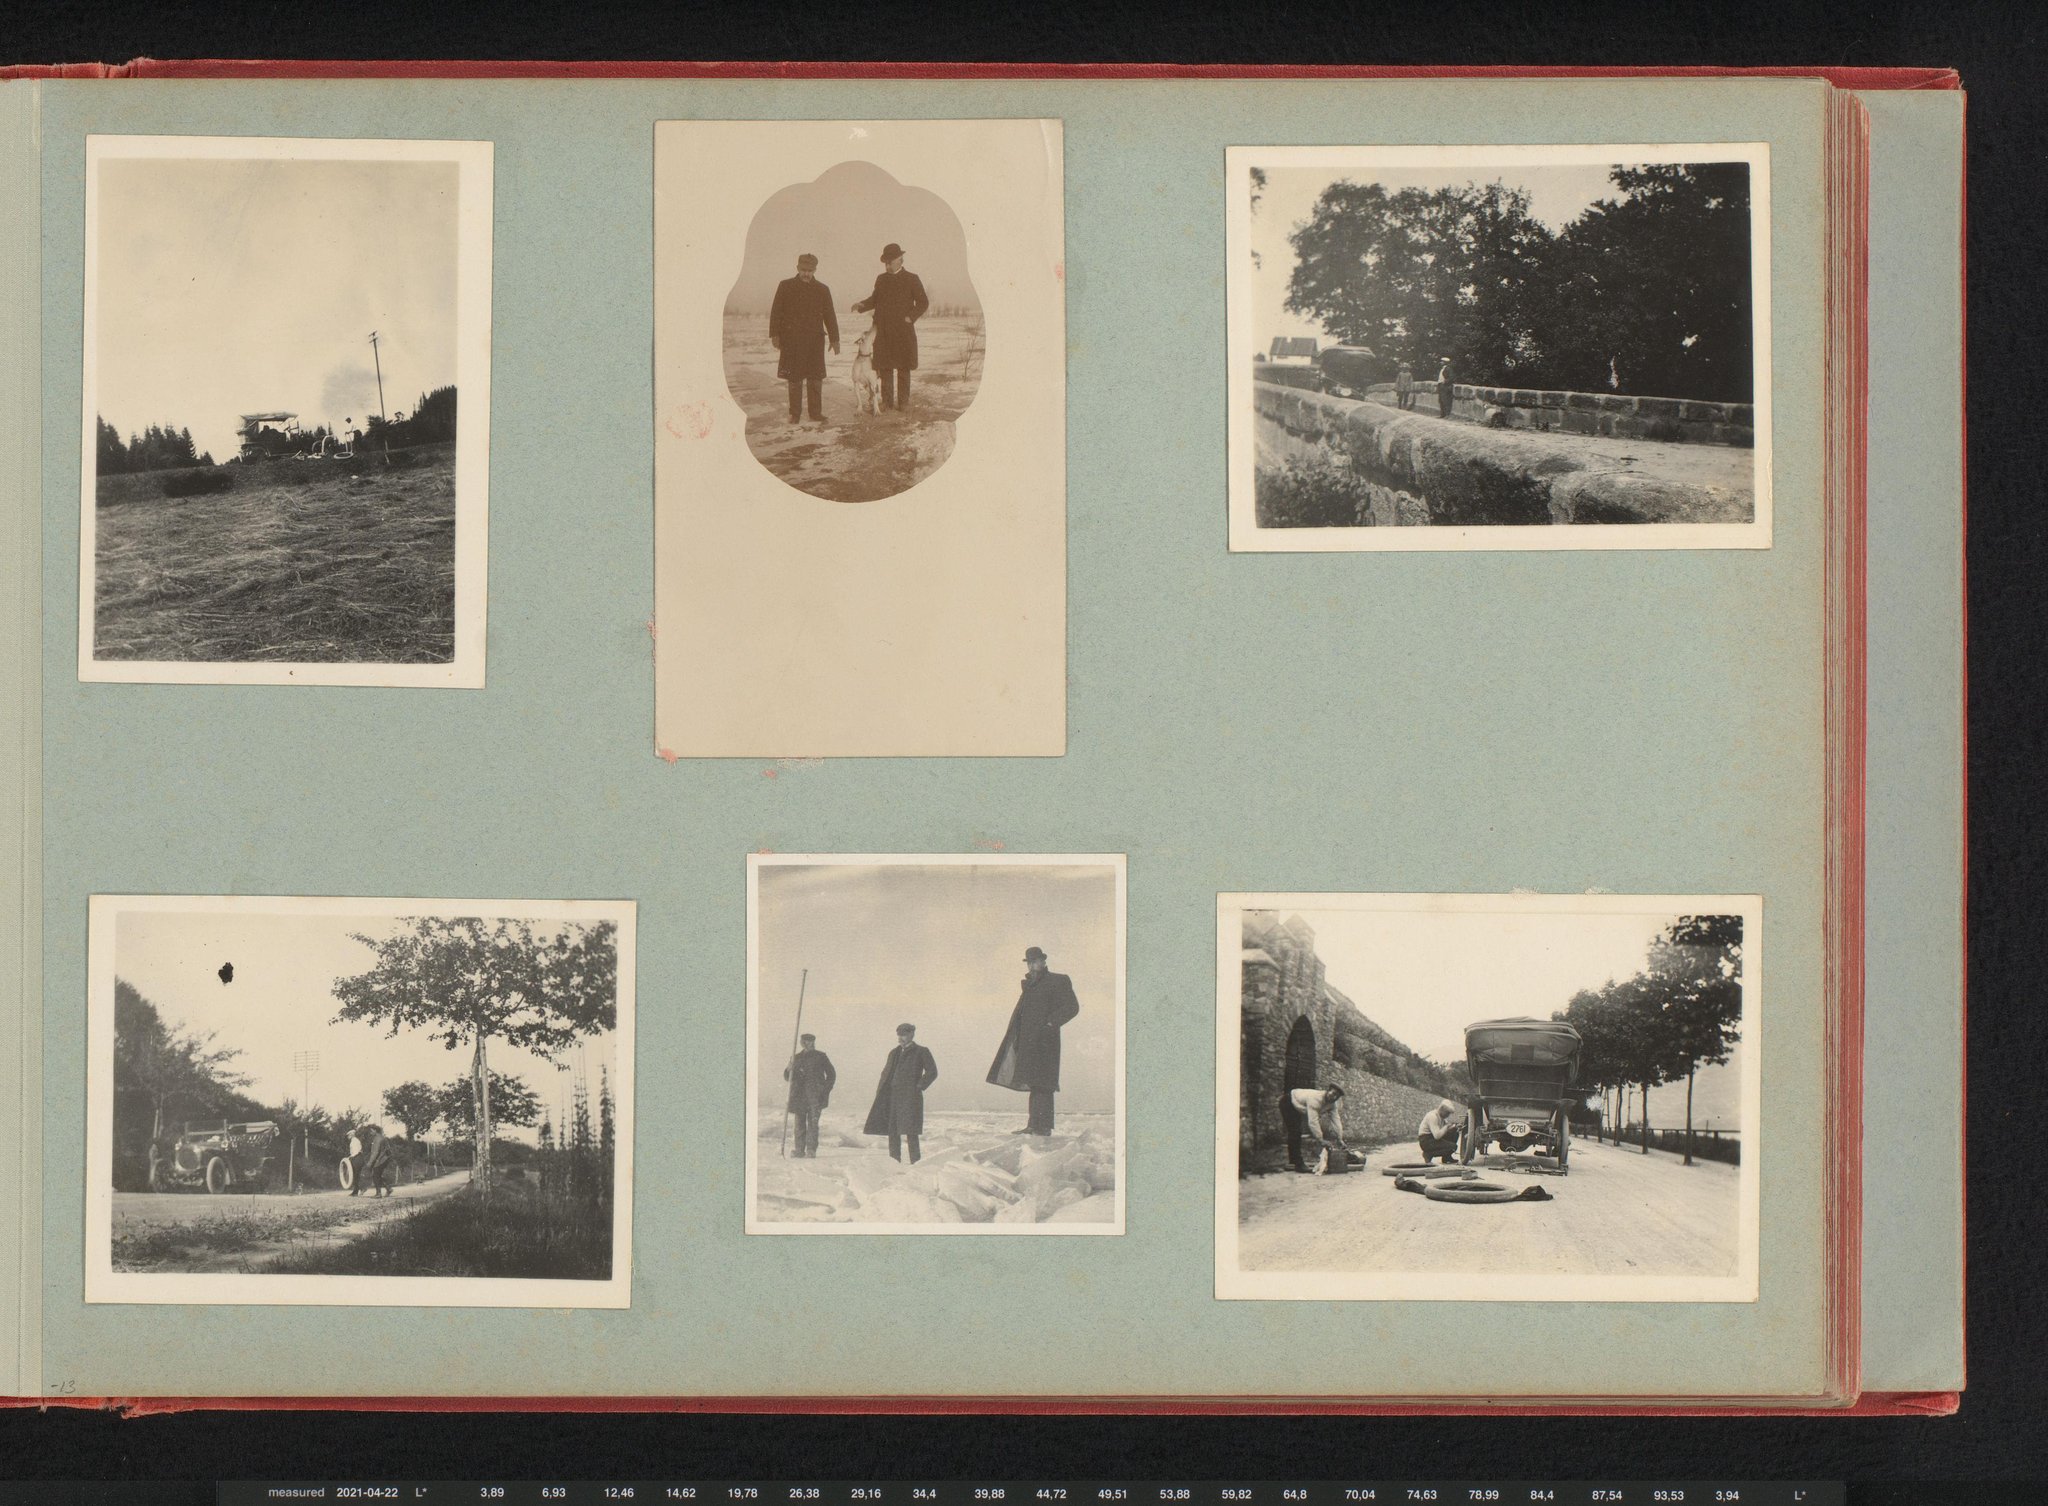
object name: photograph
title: Verwisselen van een band tijdens een autotocht en drie mannen met een hond op het ijs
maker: Anonymous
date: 1915-1925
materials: paper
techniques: gelatin silver print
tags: ice ~ freezing weather, automobile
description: Deze foto's zijn onderdeel van een album.